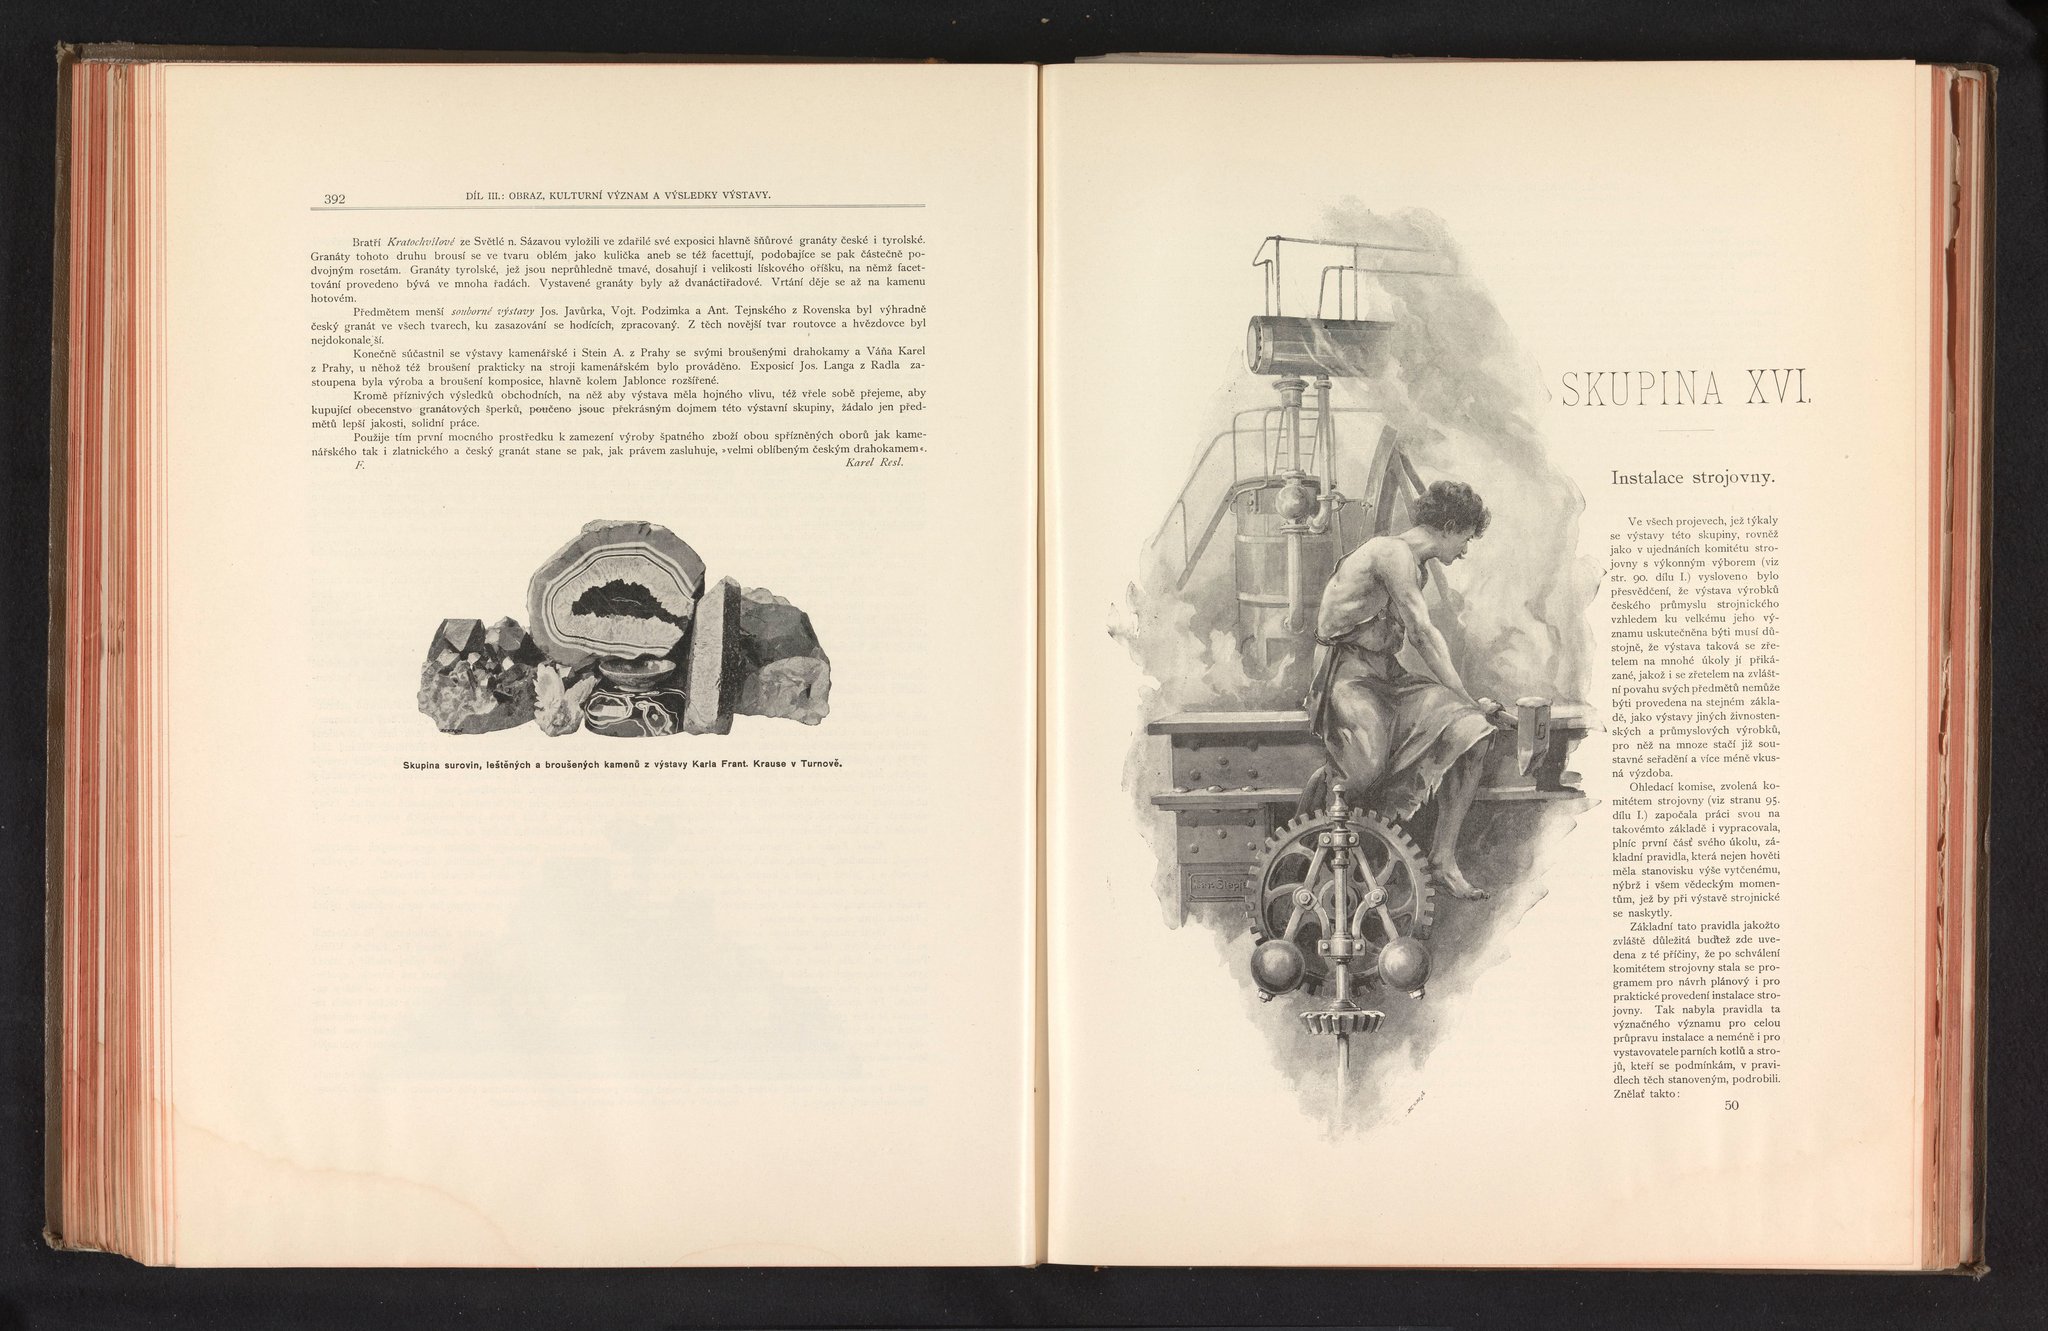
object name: page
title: Uitstalling van stenen en hout uit Turnov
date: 1890-1895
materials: paper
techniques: autotype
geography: prague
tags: rock types; minerals and metals; soil types